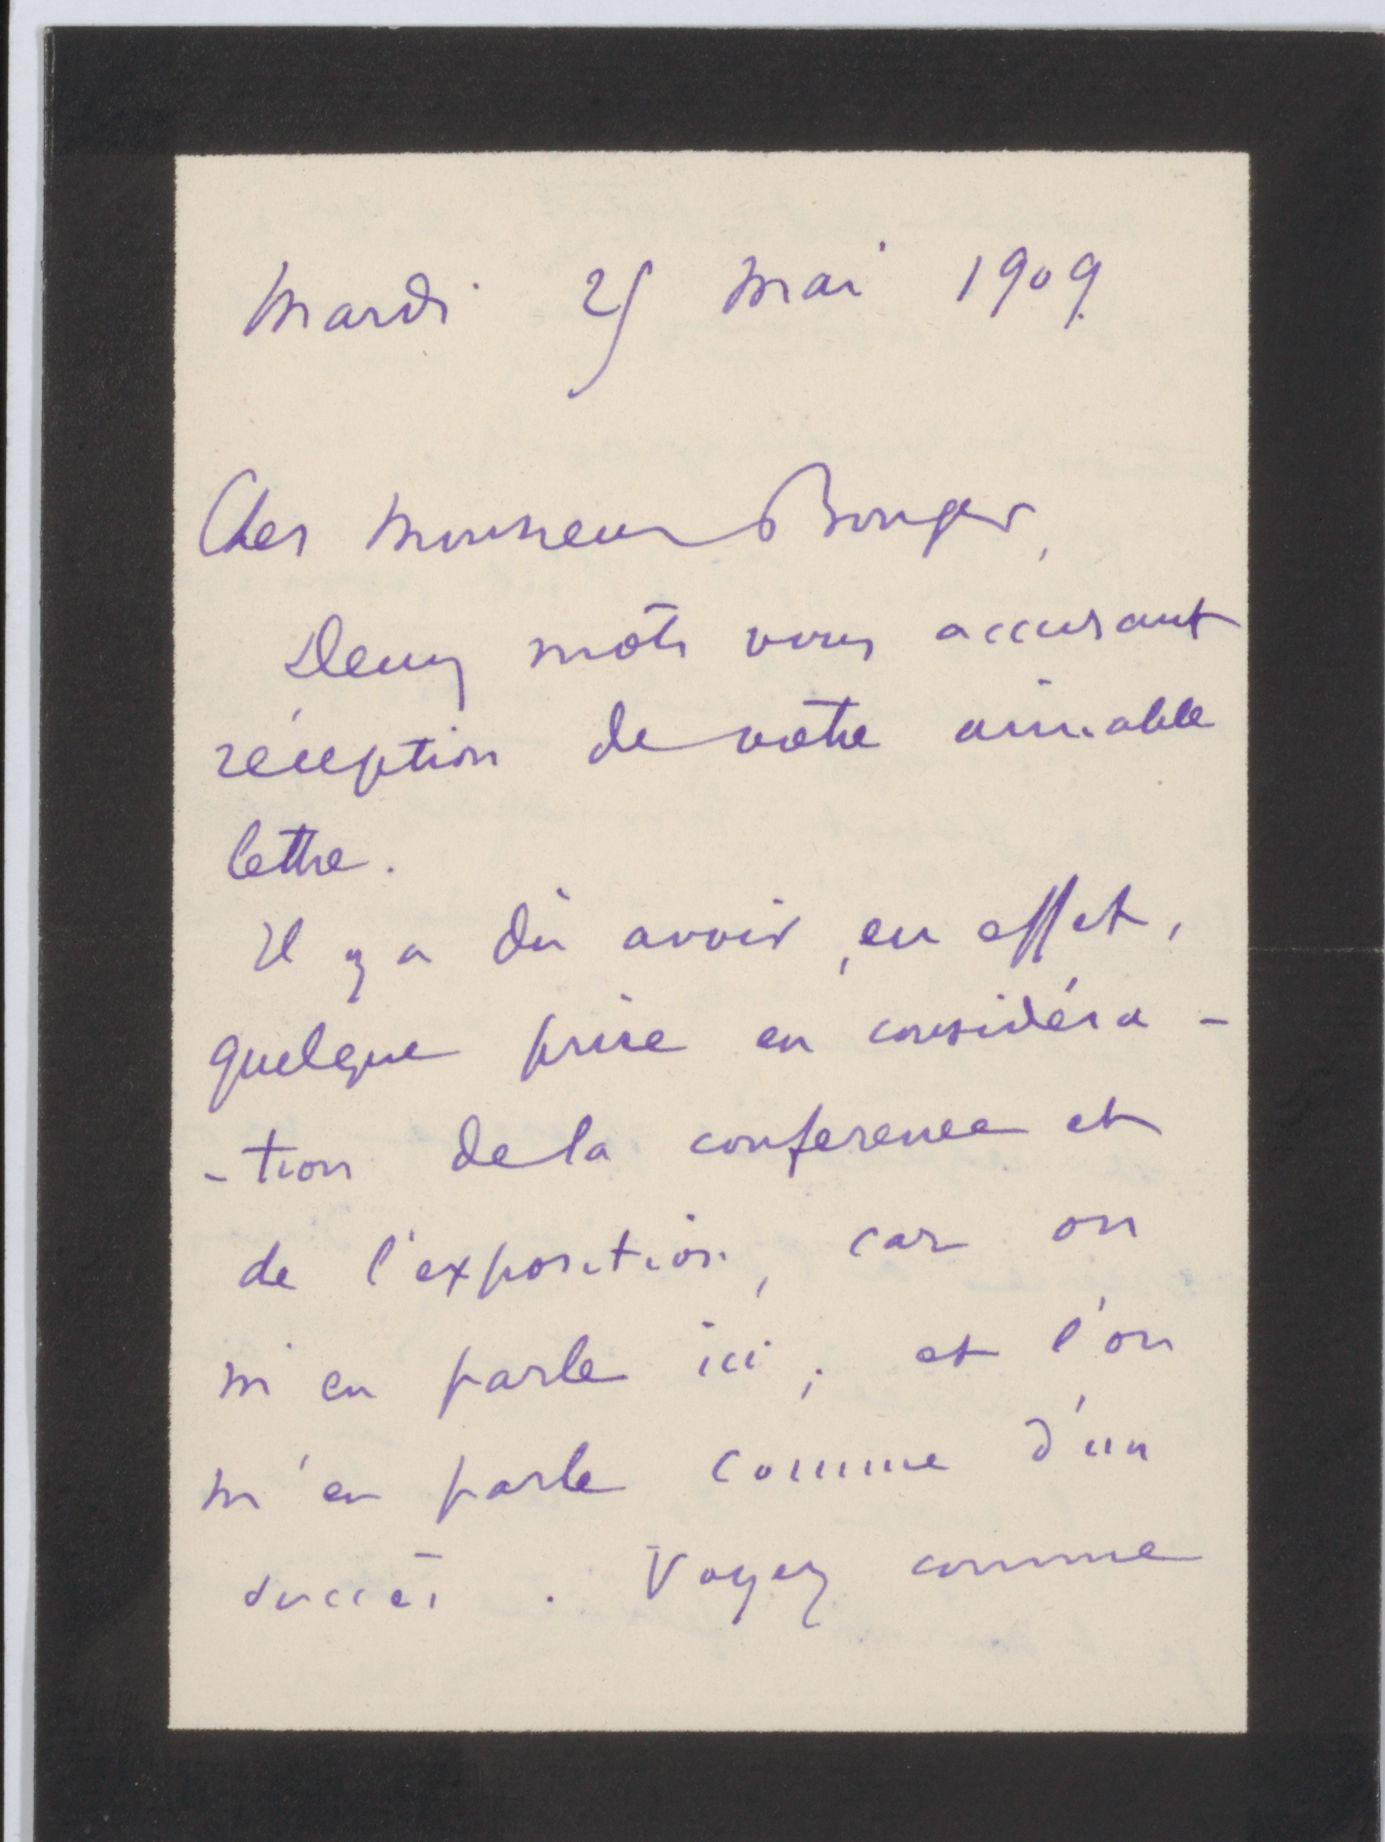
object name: letter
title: Brief aan Andries Bonger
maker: odilon redon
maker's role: draughtsman, painter, print maker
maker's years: 1840-1916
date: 1909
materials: ink, paper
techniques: pen, writing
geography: paris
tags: andries bonger, amsterdam, johanna bonger, exhibition ~ art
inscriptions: watermark